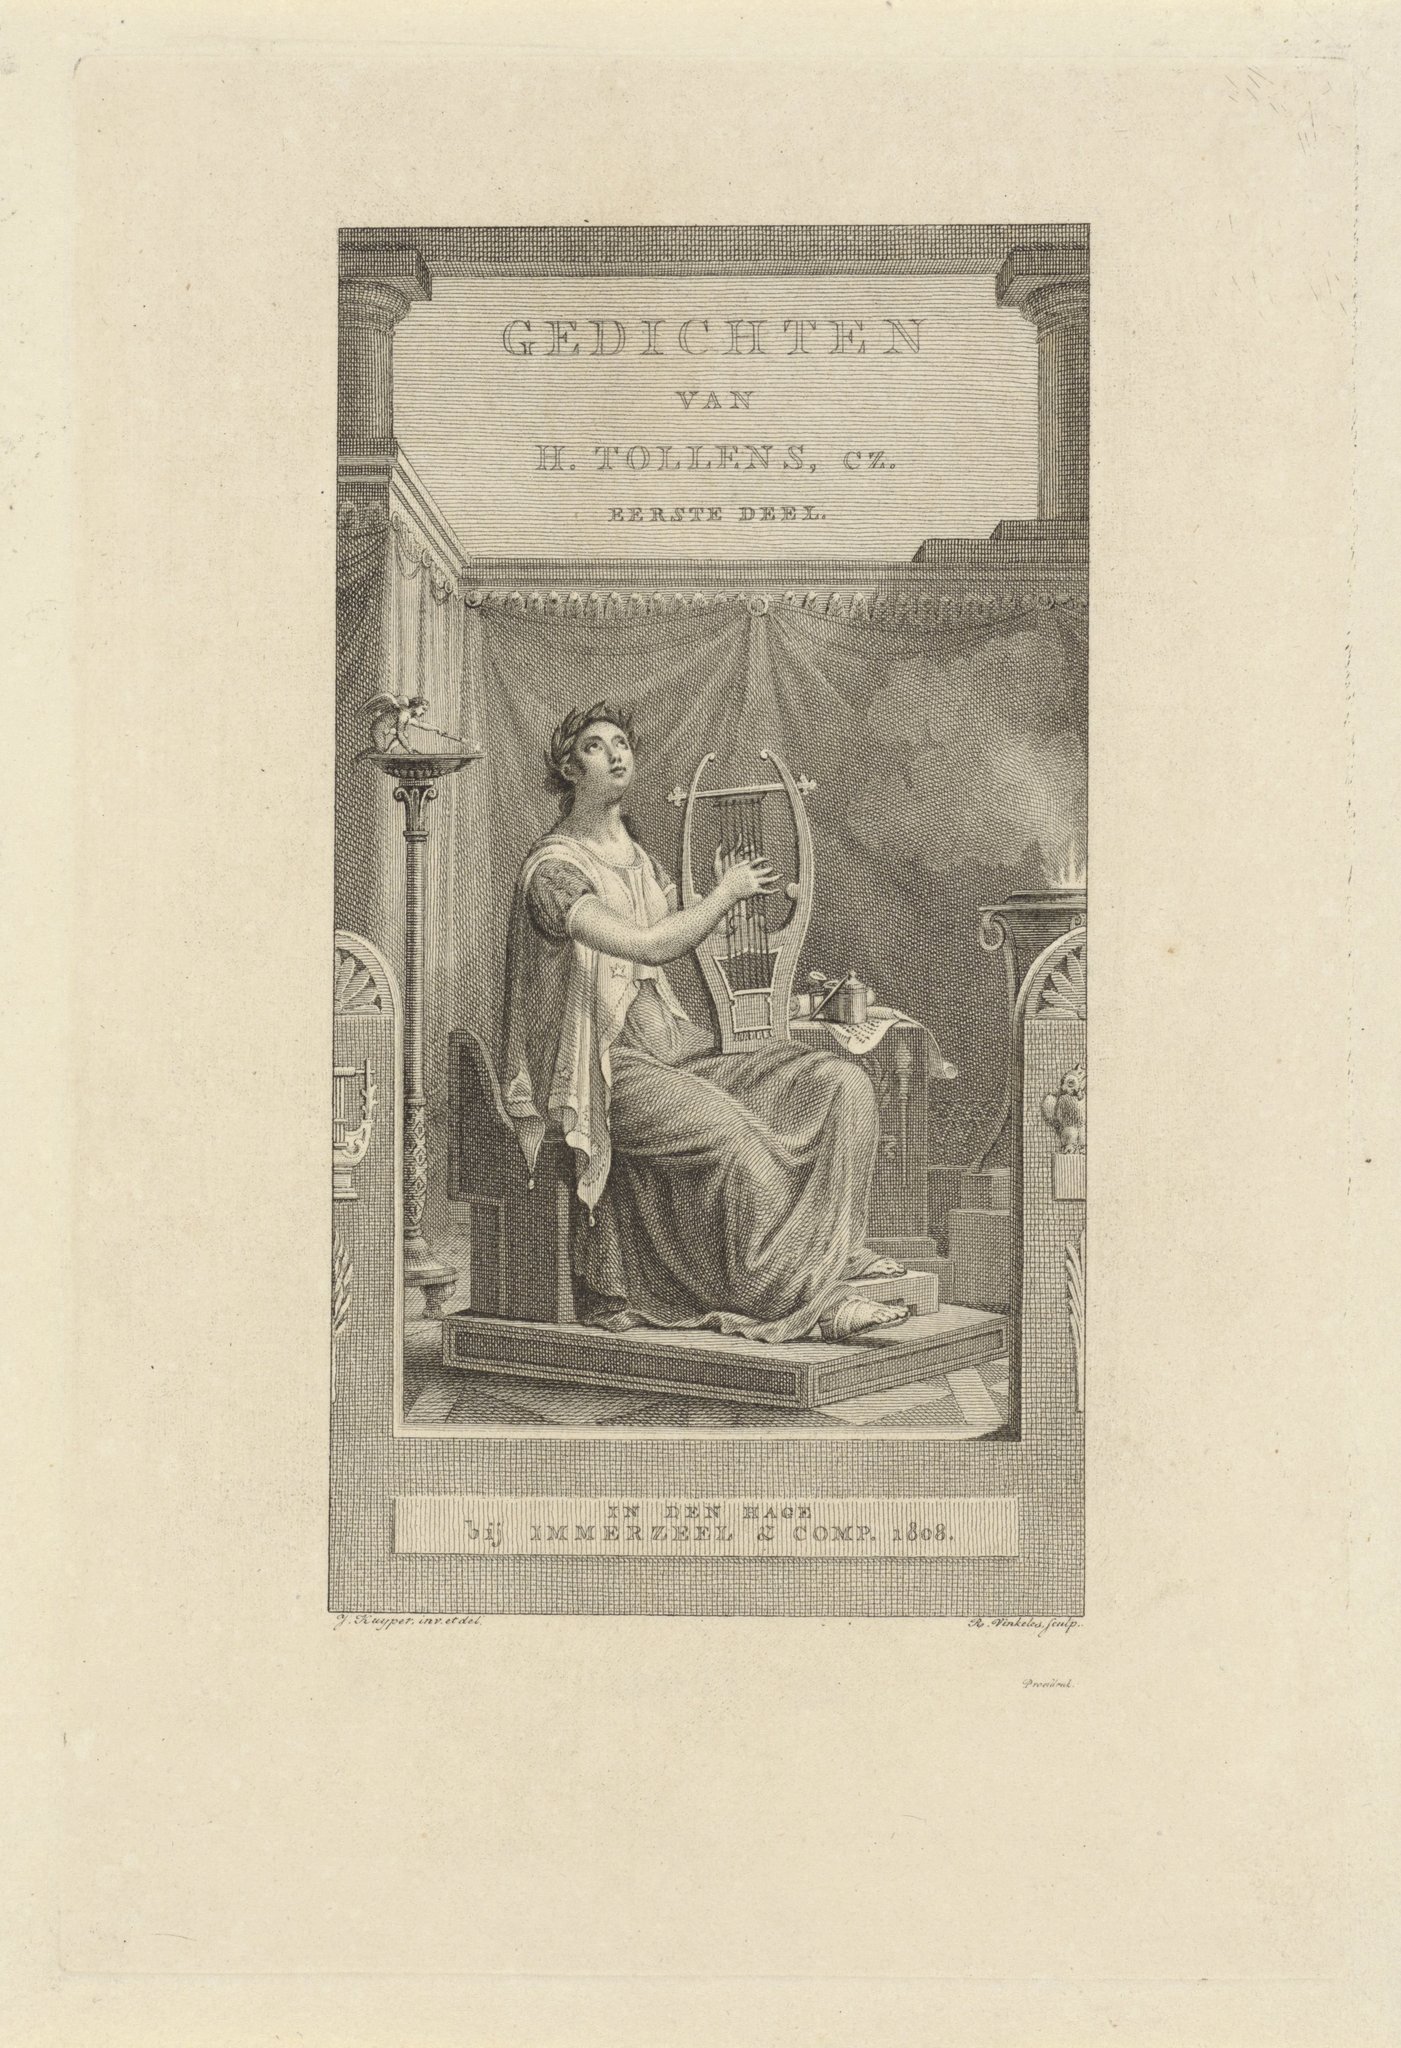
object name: print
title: Titelpagina voor "Gedichten van H. Tollens Cz., deel 1', 1808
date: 1808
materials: paper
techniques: engraving, etching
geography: the hague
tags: harp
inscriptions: collector's mark: Lugt 2228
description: Proefdruk van titelpagina voor: Tollens Cz, Henricus Franciscus. Gedichten van H. Tollens Cz., eerste deel. Den Haag: Immerzeel en comp., 1808.